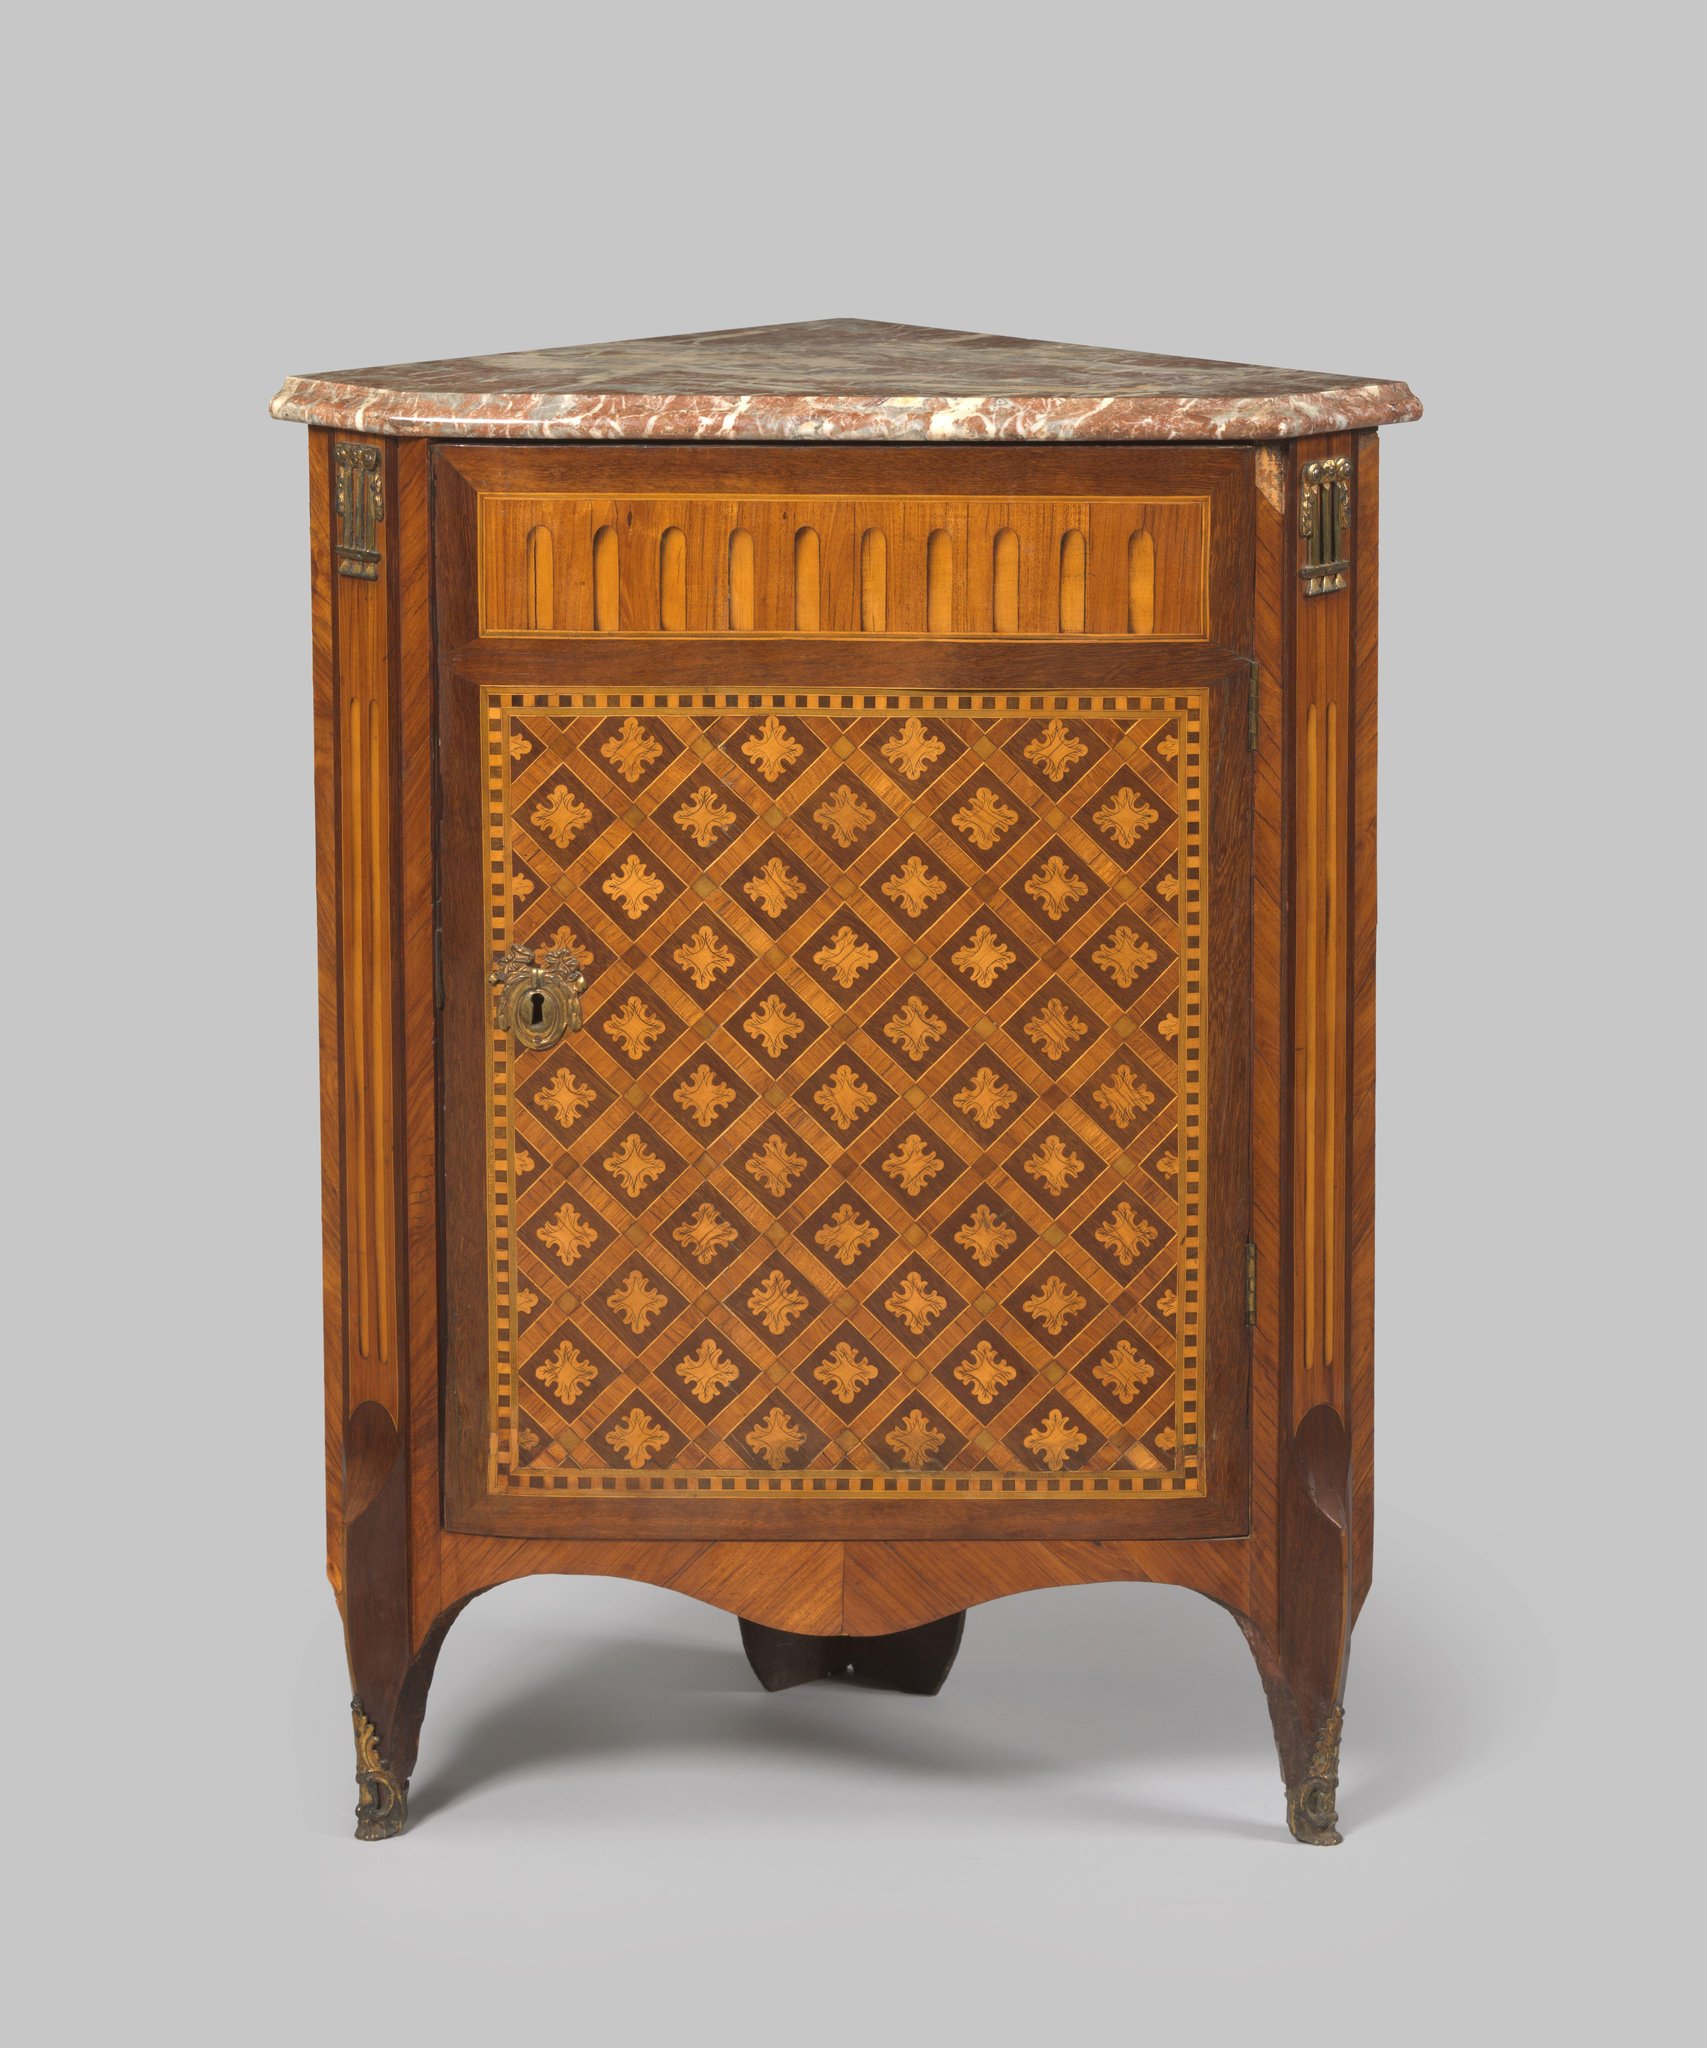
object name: cupboard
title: Hoekkast met marqueterie in ruitpatroon met rozetten. Blad van bruin-wit-grijs geaderd marmer. Beslag van koper.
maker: Anonymous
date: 1750-1800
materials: copper, wood, marble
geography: france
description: Kleine hoekkast, aan de achterkant rustend op een steunstuk en aan de voorkant op twee licht gebogen poten, versierd met koperen beslag met rocaille-motieven. De deur aan de voorzijde vertoont in marqueterie een ruitpatroon, waarin rozetten. Boven dit veld is een friesvormige versiering met schijncannelures aangebracht; eenzelfde decoratie siert ook de hoekstijlen, bekroond door koperen beslag. Het bruin-grijs-wit geaderd marmeren blad is aan de voorzijde geprofileerd. Sleutelplaat met krans en strikmotief.